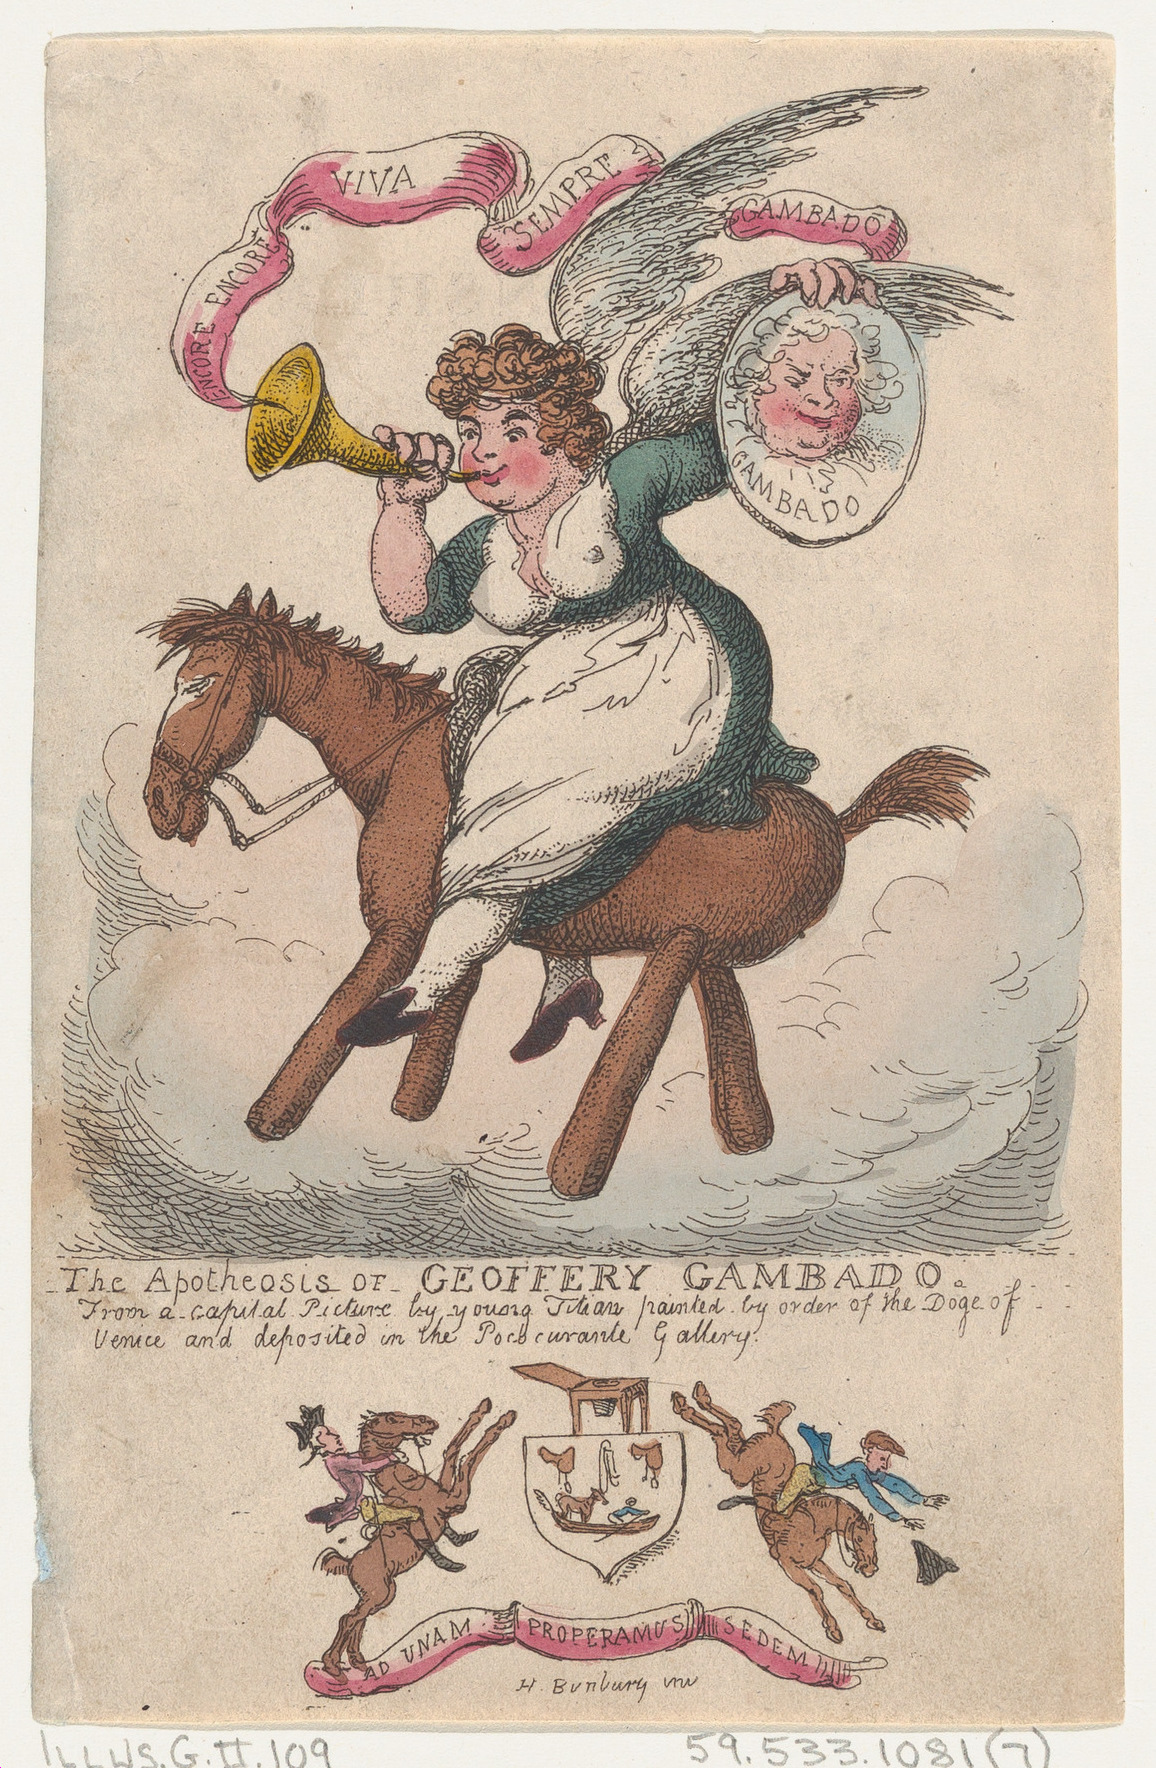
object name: print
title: The Apotheosis, or, Geoffery Gambado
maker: thomas rowlandson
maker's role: artist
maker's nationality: british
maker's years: 1757-1827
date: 1808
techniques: etching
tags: satire,men,women,horses